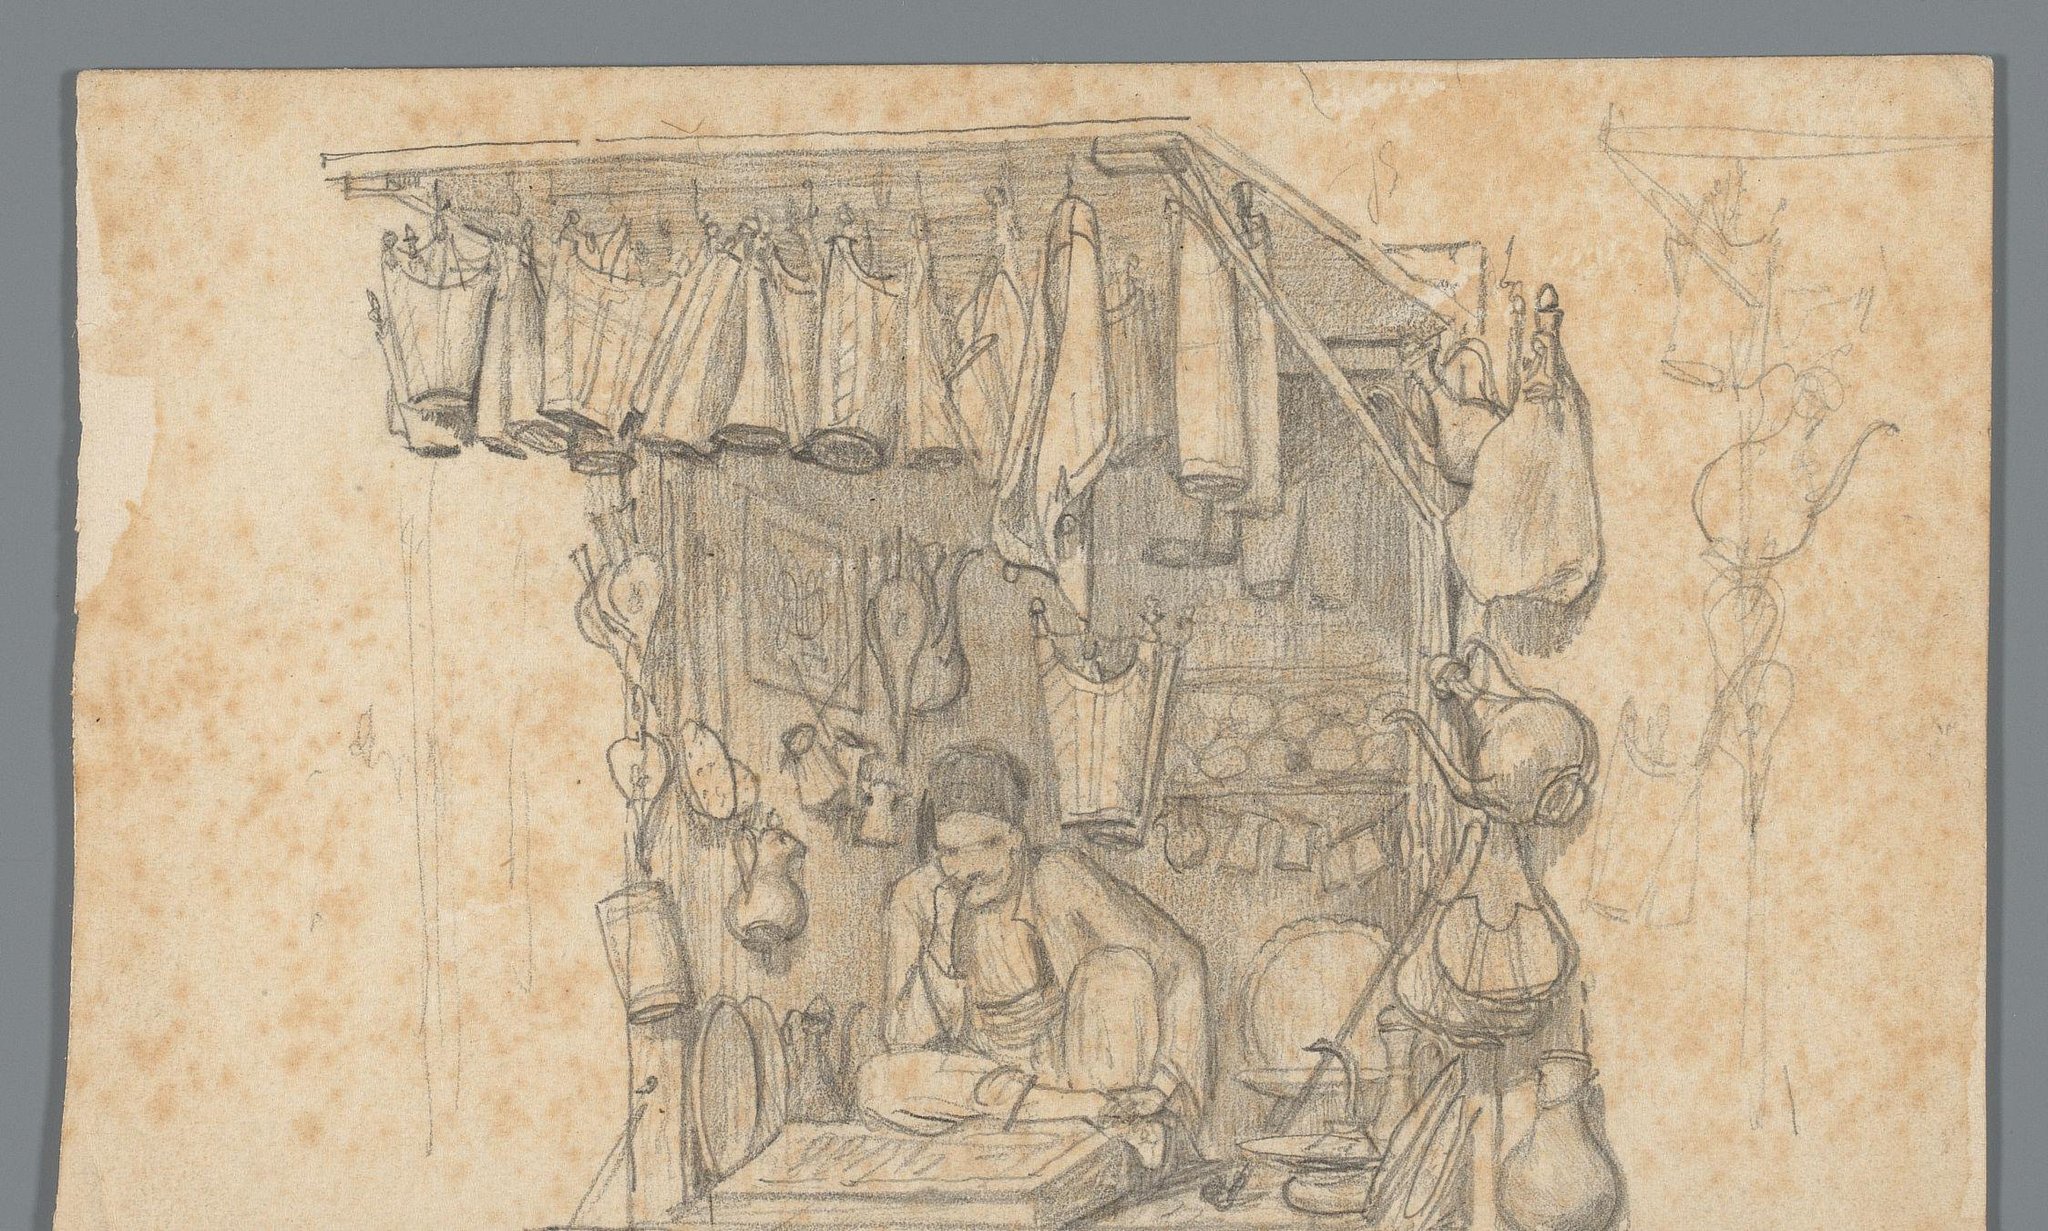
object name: drawing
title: Egyptische reis van 1858-1859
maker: willem de famars testas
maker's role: draughtsman, painter, print maker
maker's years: 1834-1896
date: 1858-1859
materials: paper, pencil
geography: egypt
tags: merchant, salesman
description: Onderdeel van 20 losse bladen met tekeningen gemaakt tijdens Famars Testas zijn Egyptische reis van 1858, met voornamelijk figuren en dorpsgezichten met notities.